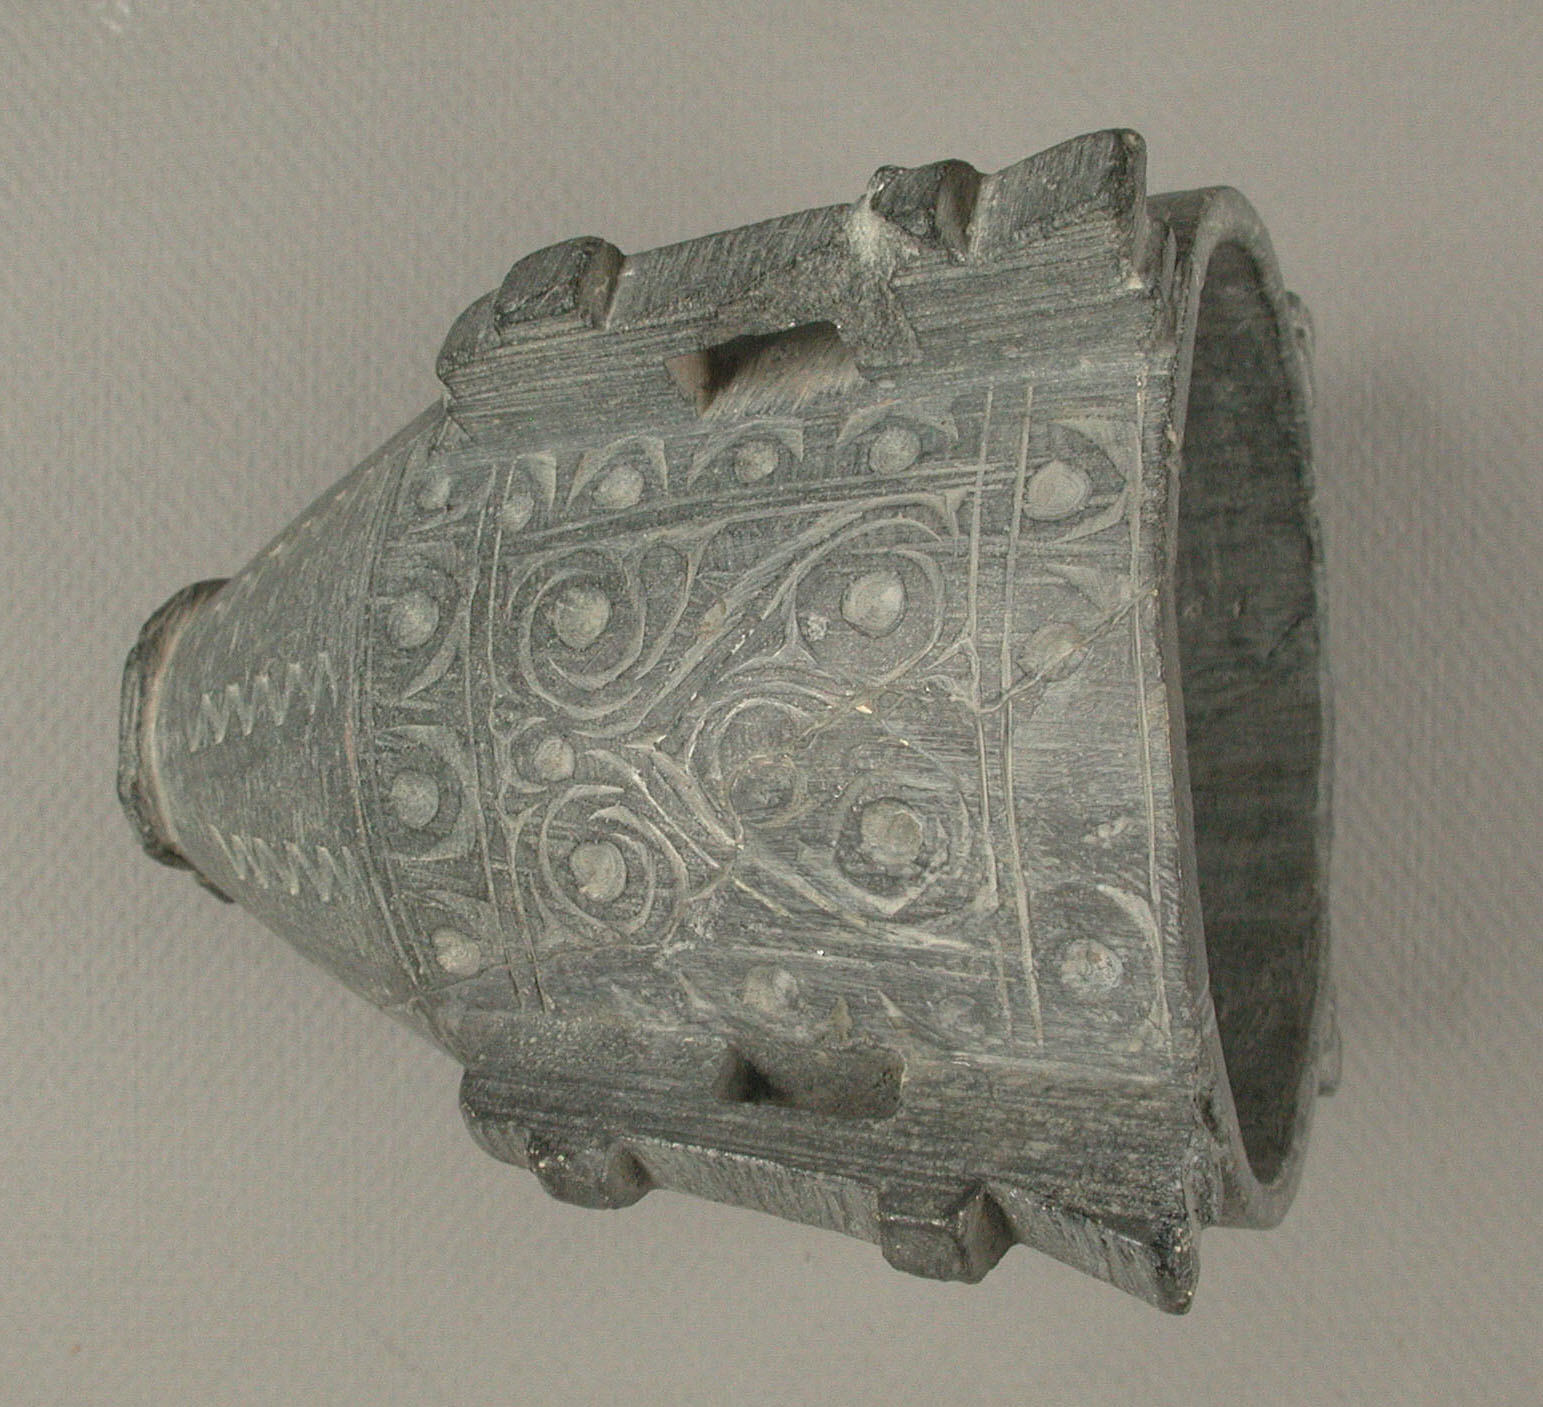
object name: vase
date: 1001-1100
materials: stone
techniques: carving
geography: iran